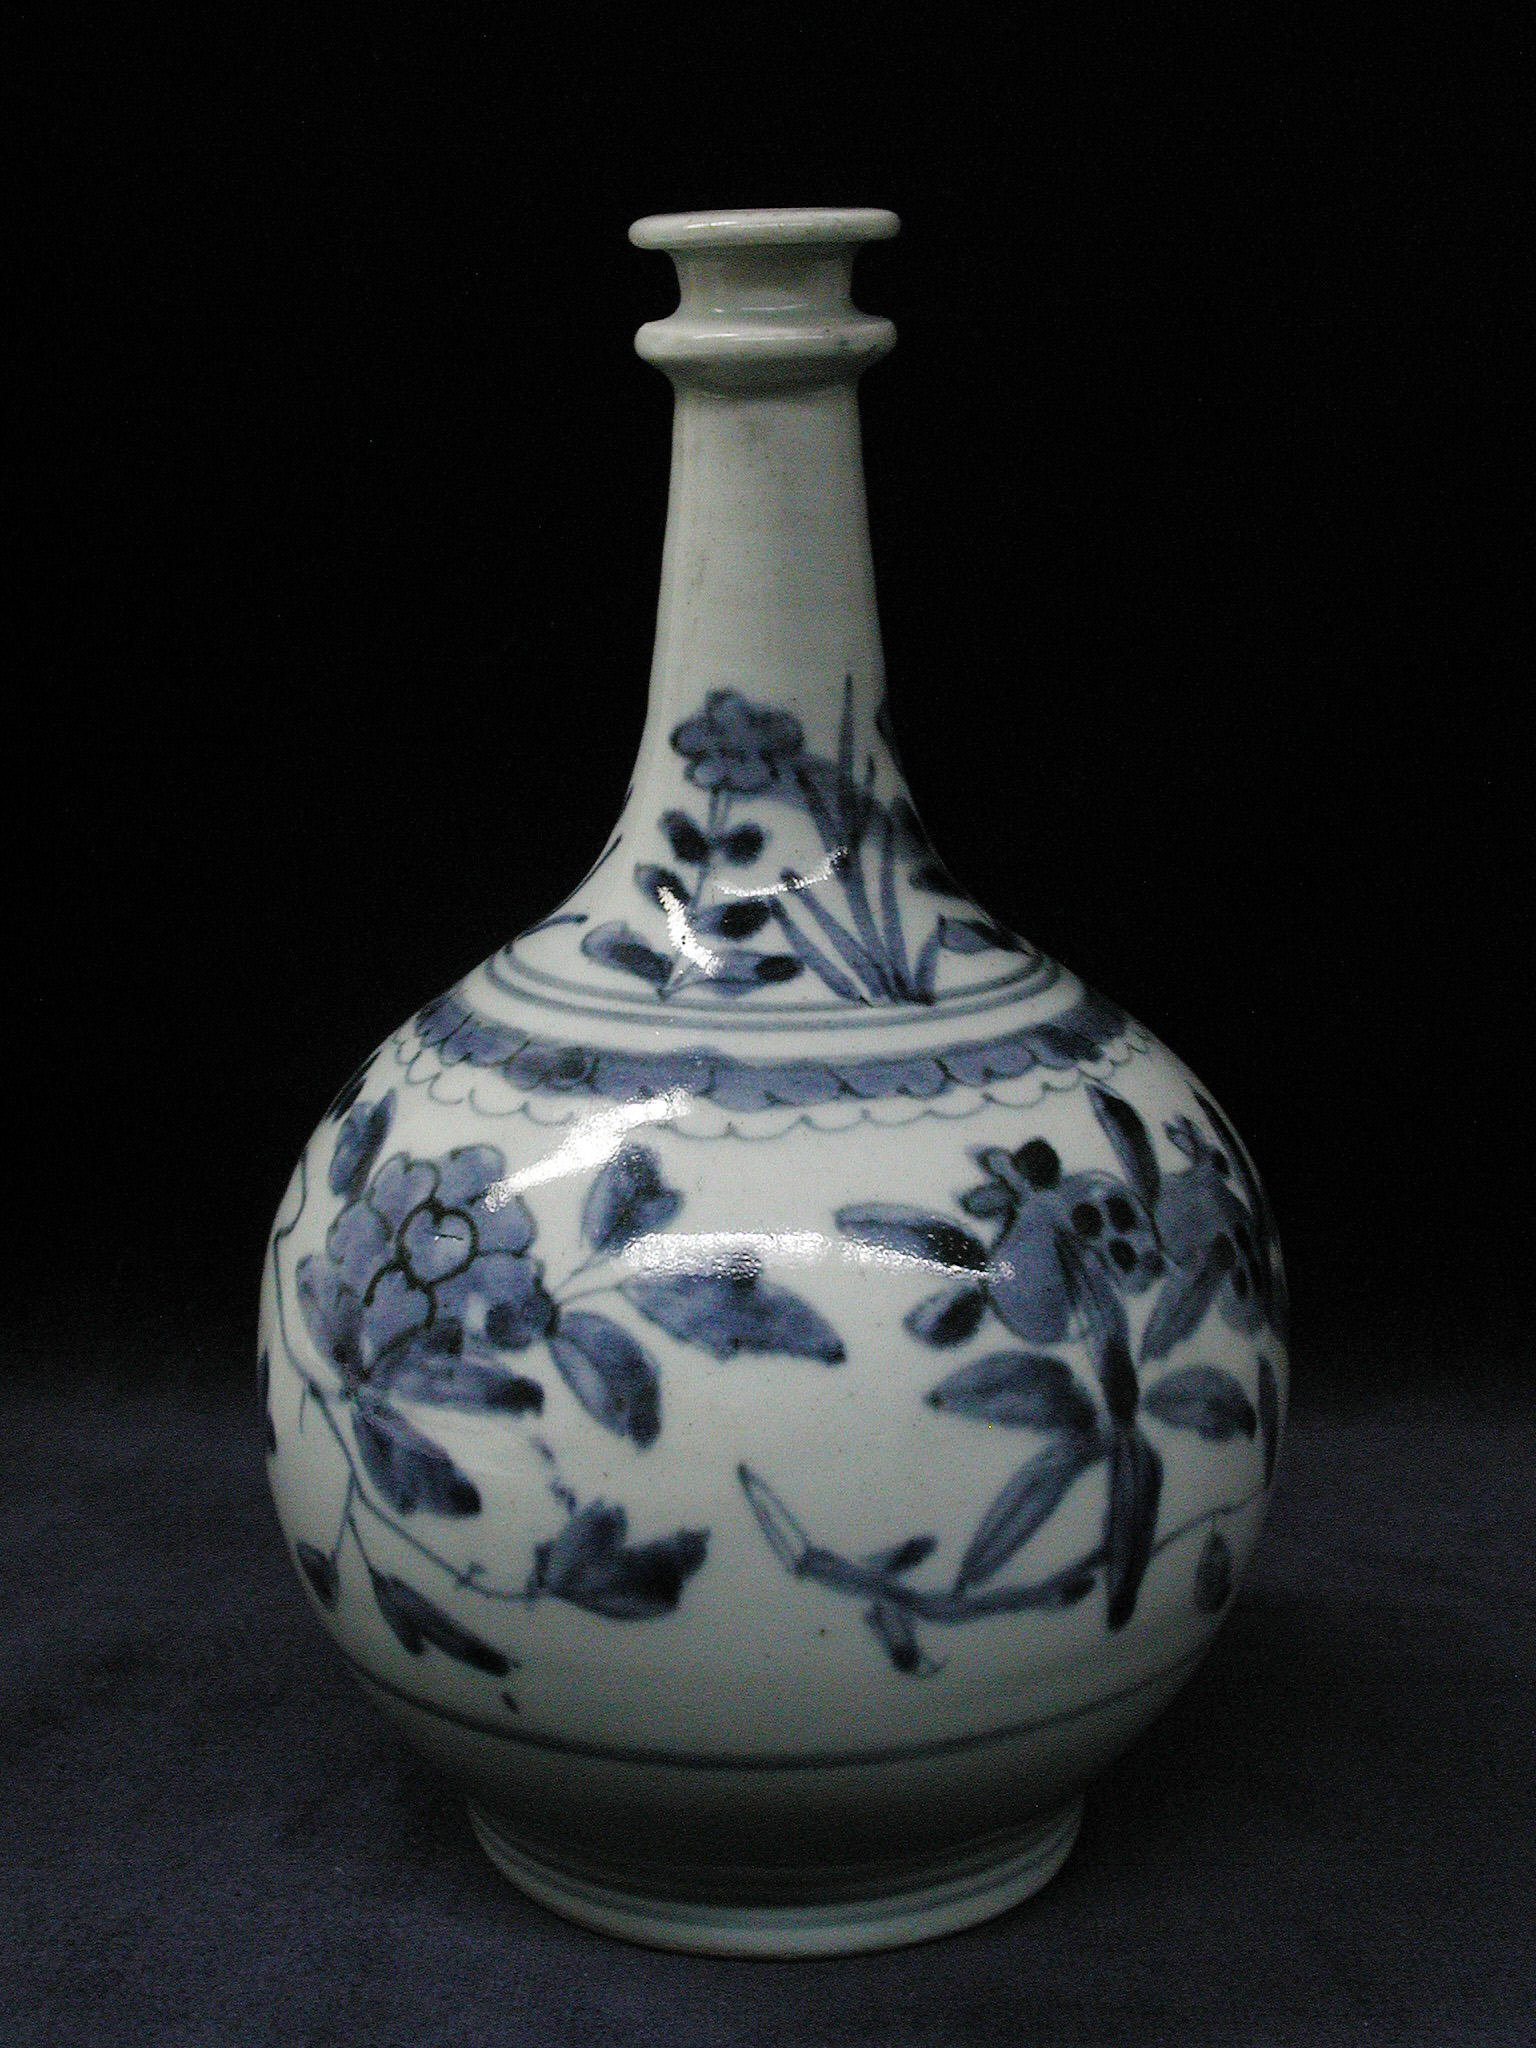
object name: bottle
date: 1701-1733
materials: hard paste porcelain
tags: flowers